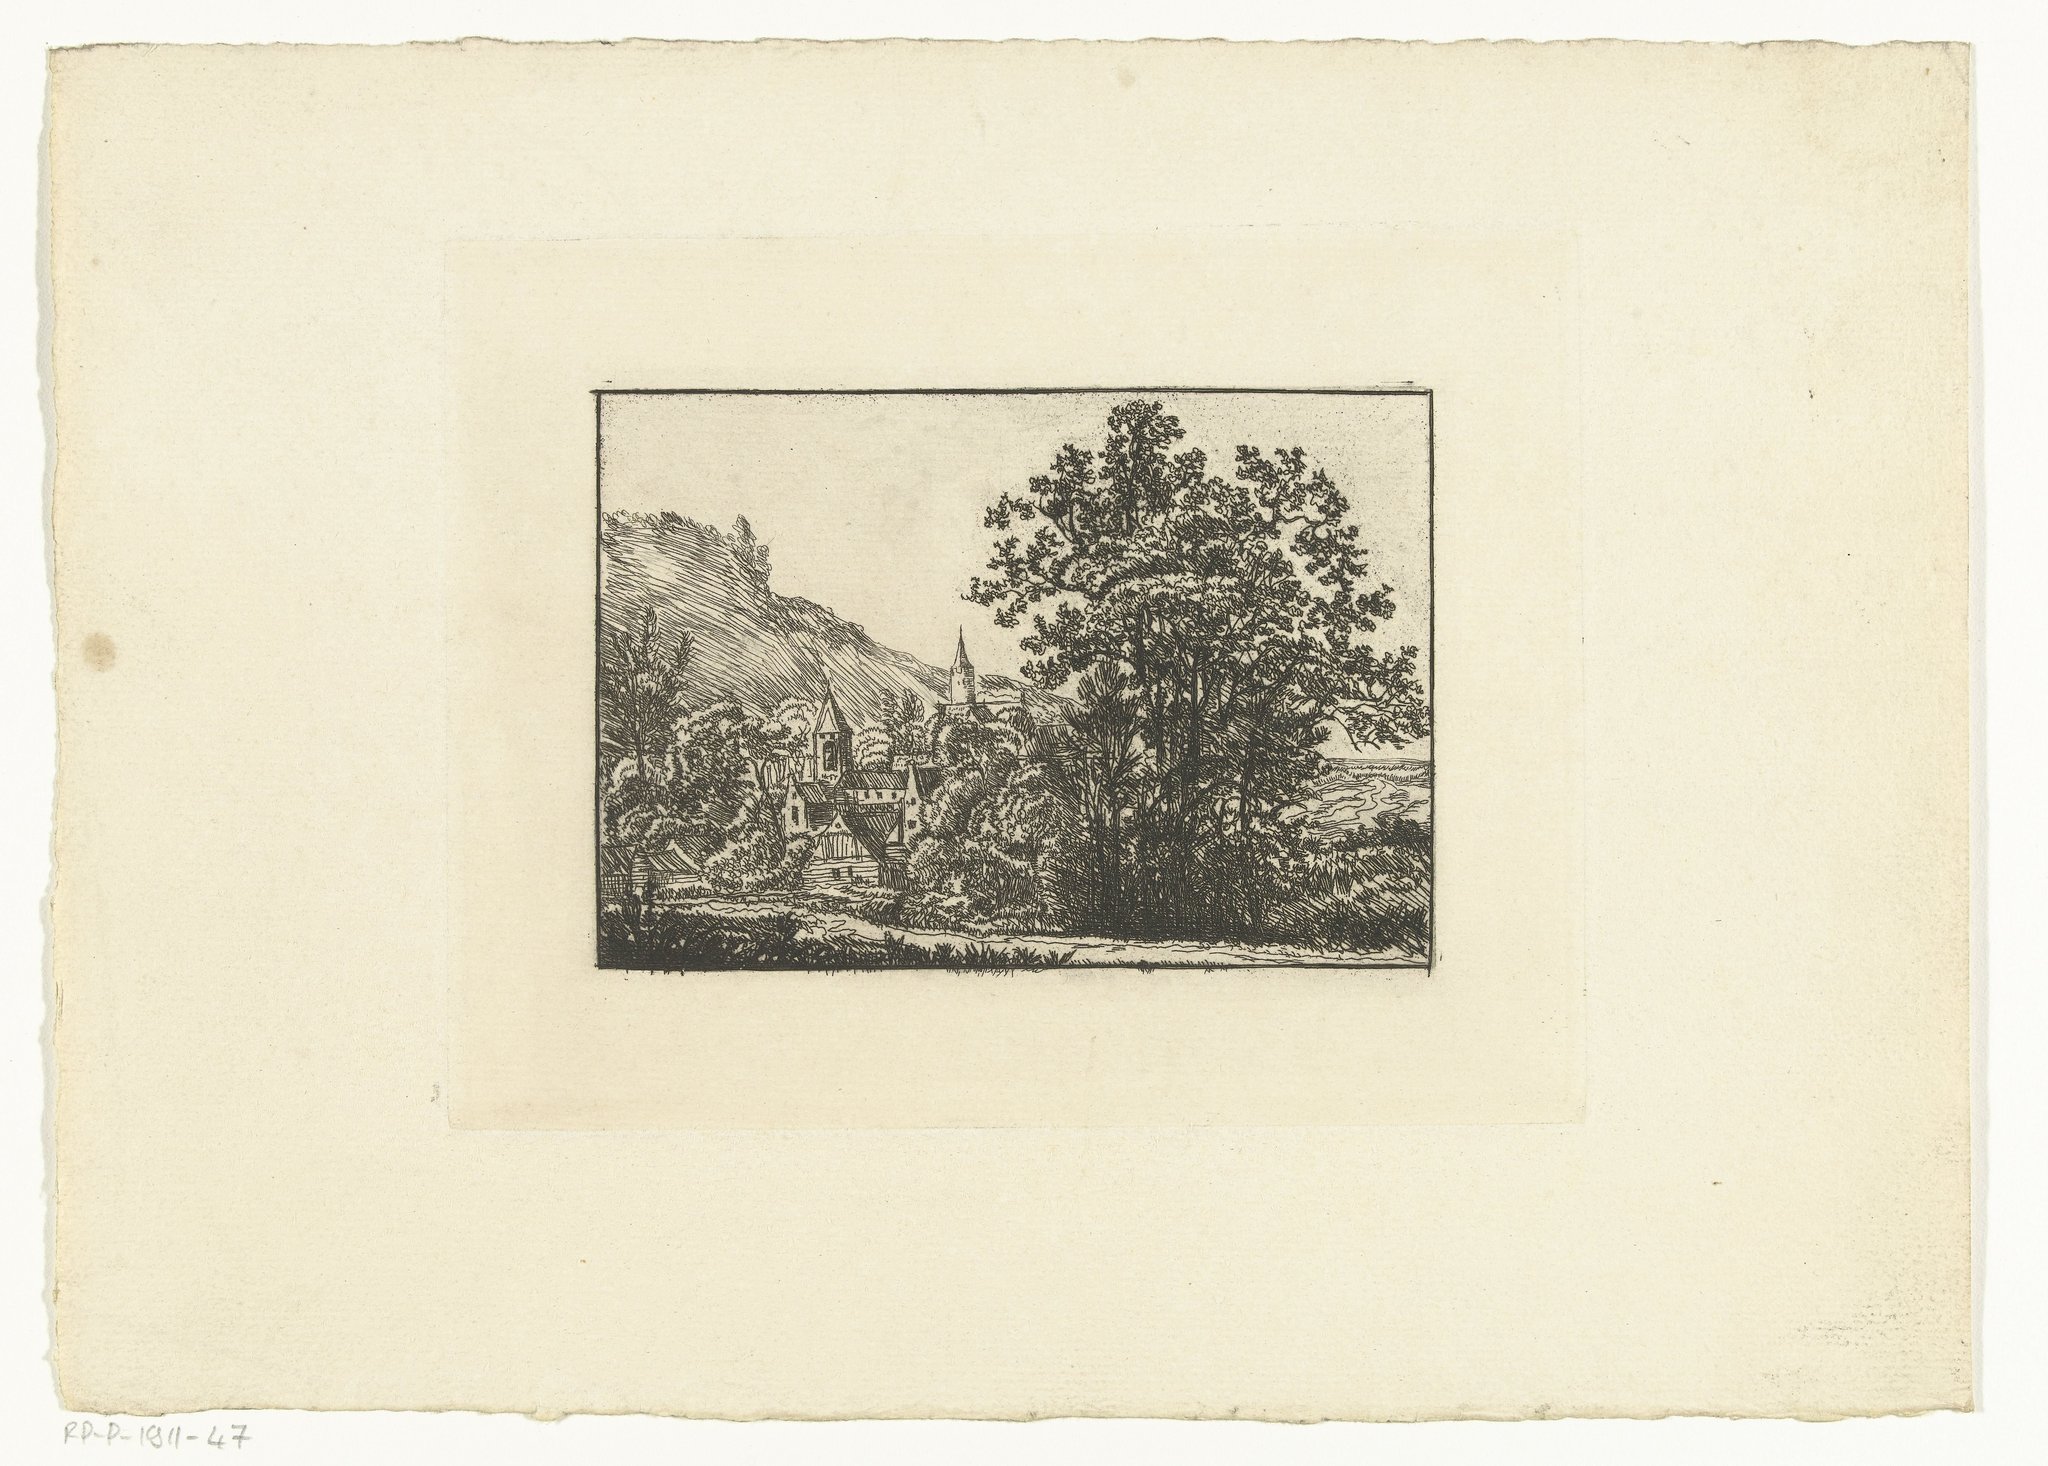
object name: print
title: Landschap met dorp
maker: johannes arnoldus boland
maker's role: print maker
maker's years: 1838-1922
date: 1860-1900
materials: paper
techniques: etching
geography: amsterdam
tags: landscapes in the temperate zone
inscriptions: collector's mark: Lugt 2228